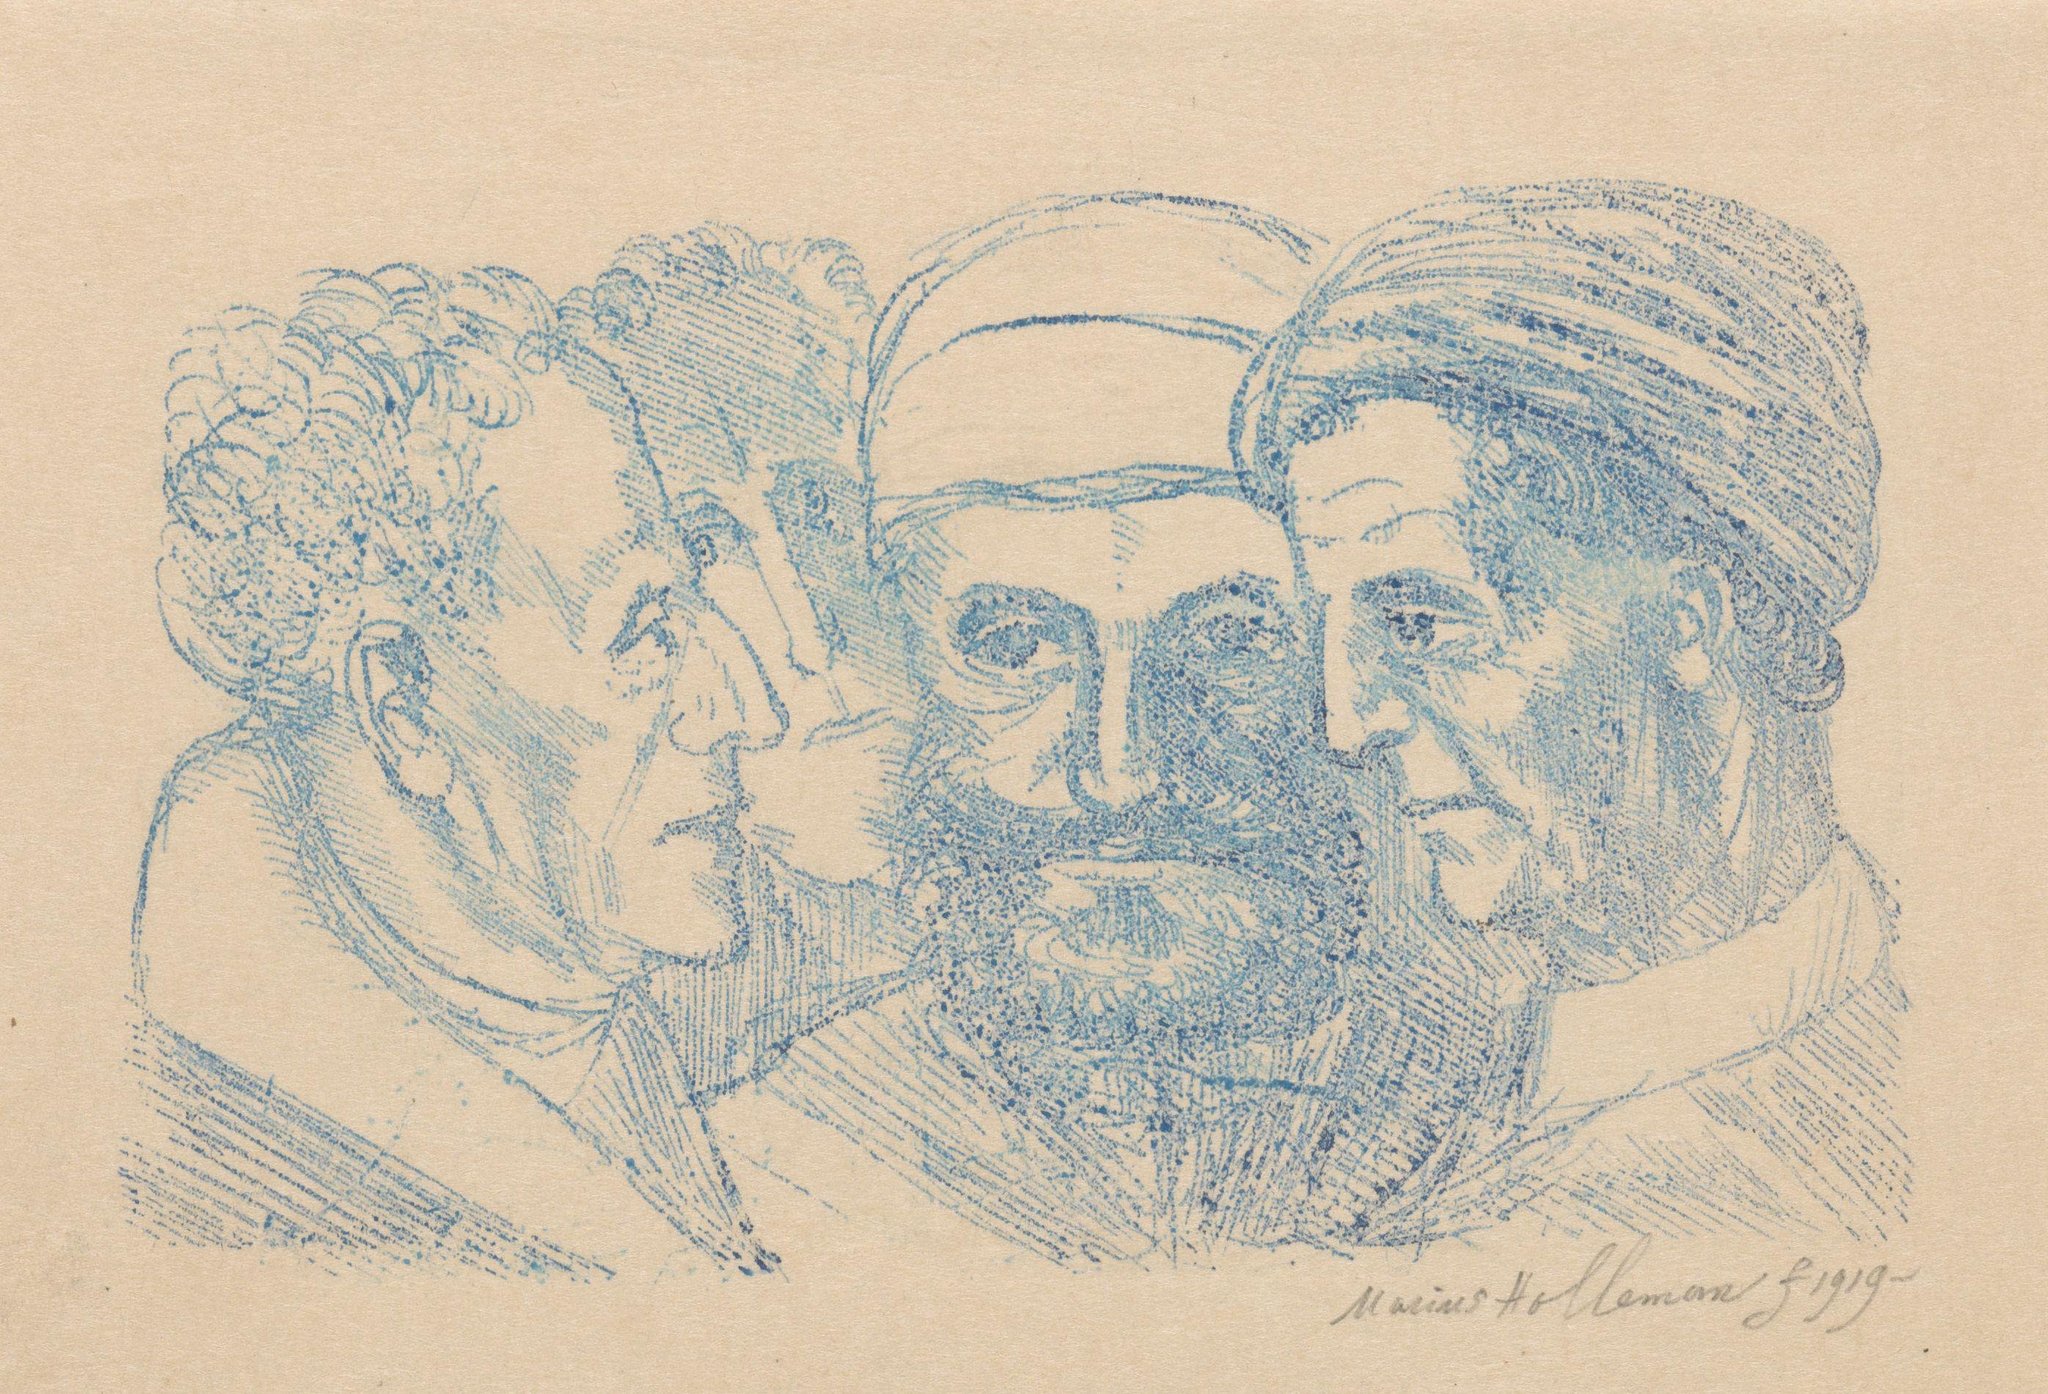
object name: print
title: Vier mannenhoofden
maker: marius holleman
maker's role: draughtsman, print maker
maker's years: 1878-1926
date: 1919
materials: paper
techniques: etching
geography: groningen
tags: adult man, head-gear: hat, beard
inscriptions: collector's mark: Lugt 2228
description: De meest rechtse man draagt een muts, de man naast hem heeft een baard. De meest rechtse en meest linkse man en profil.